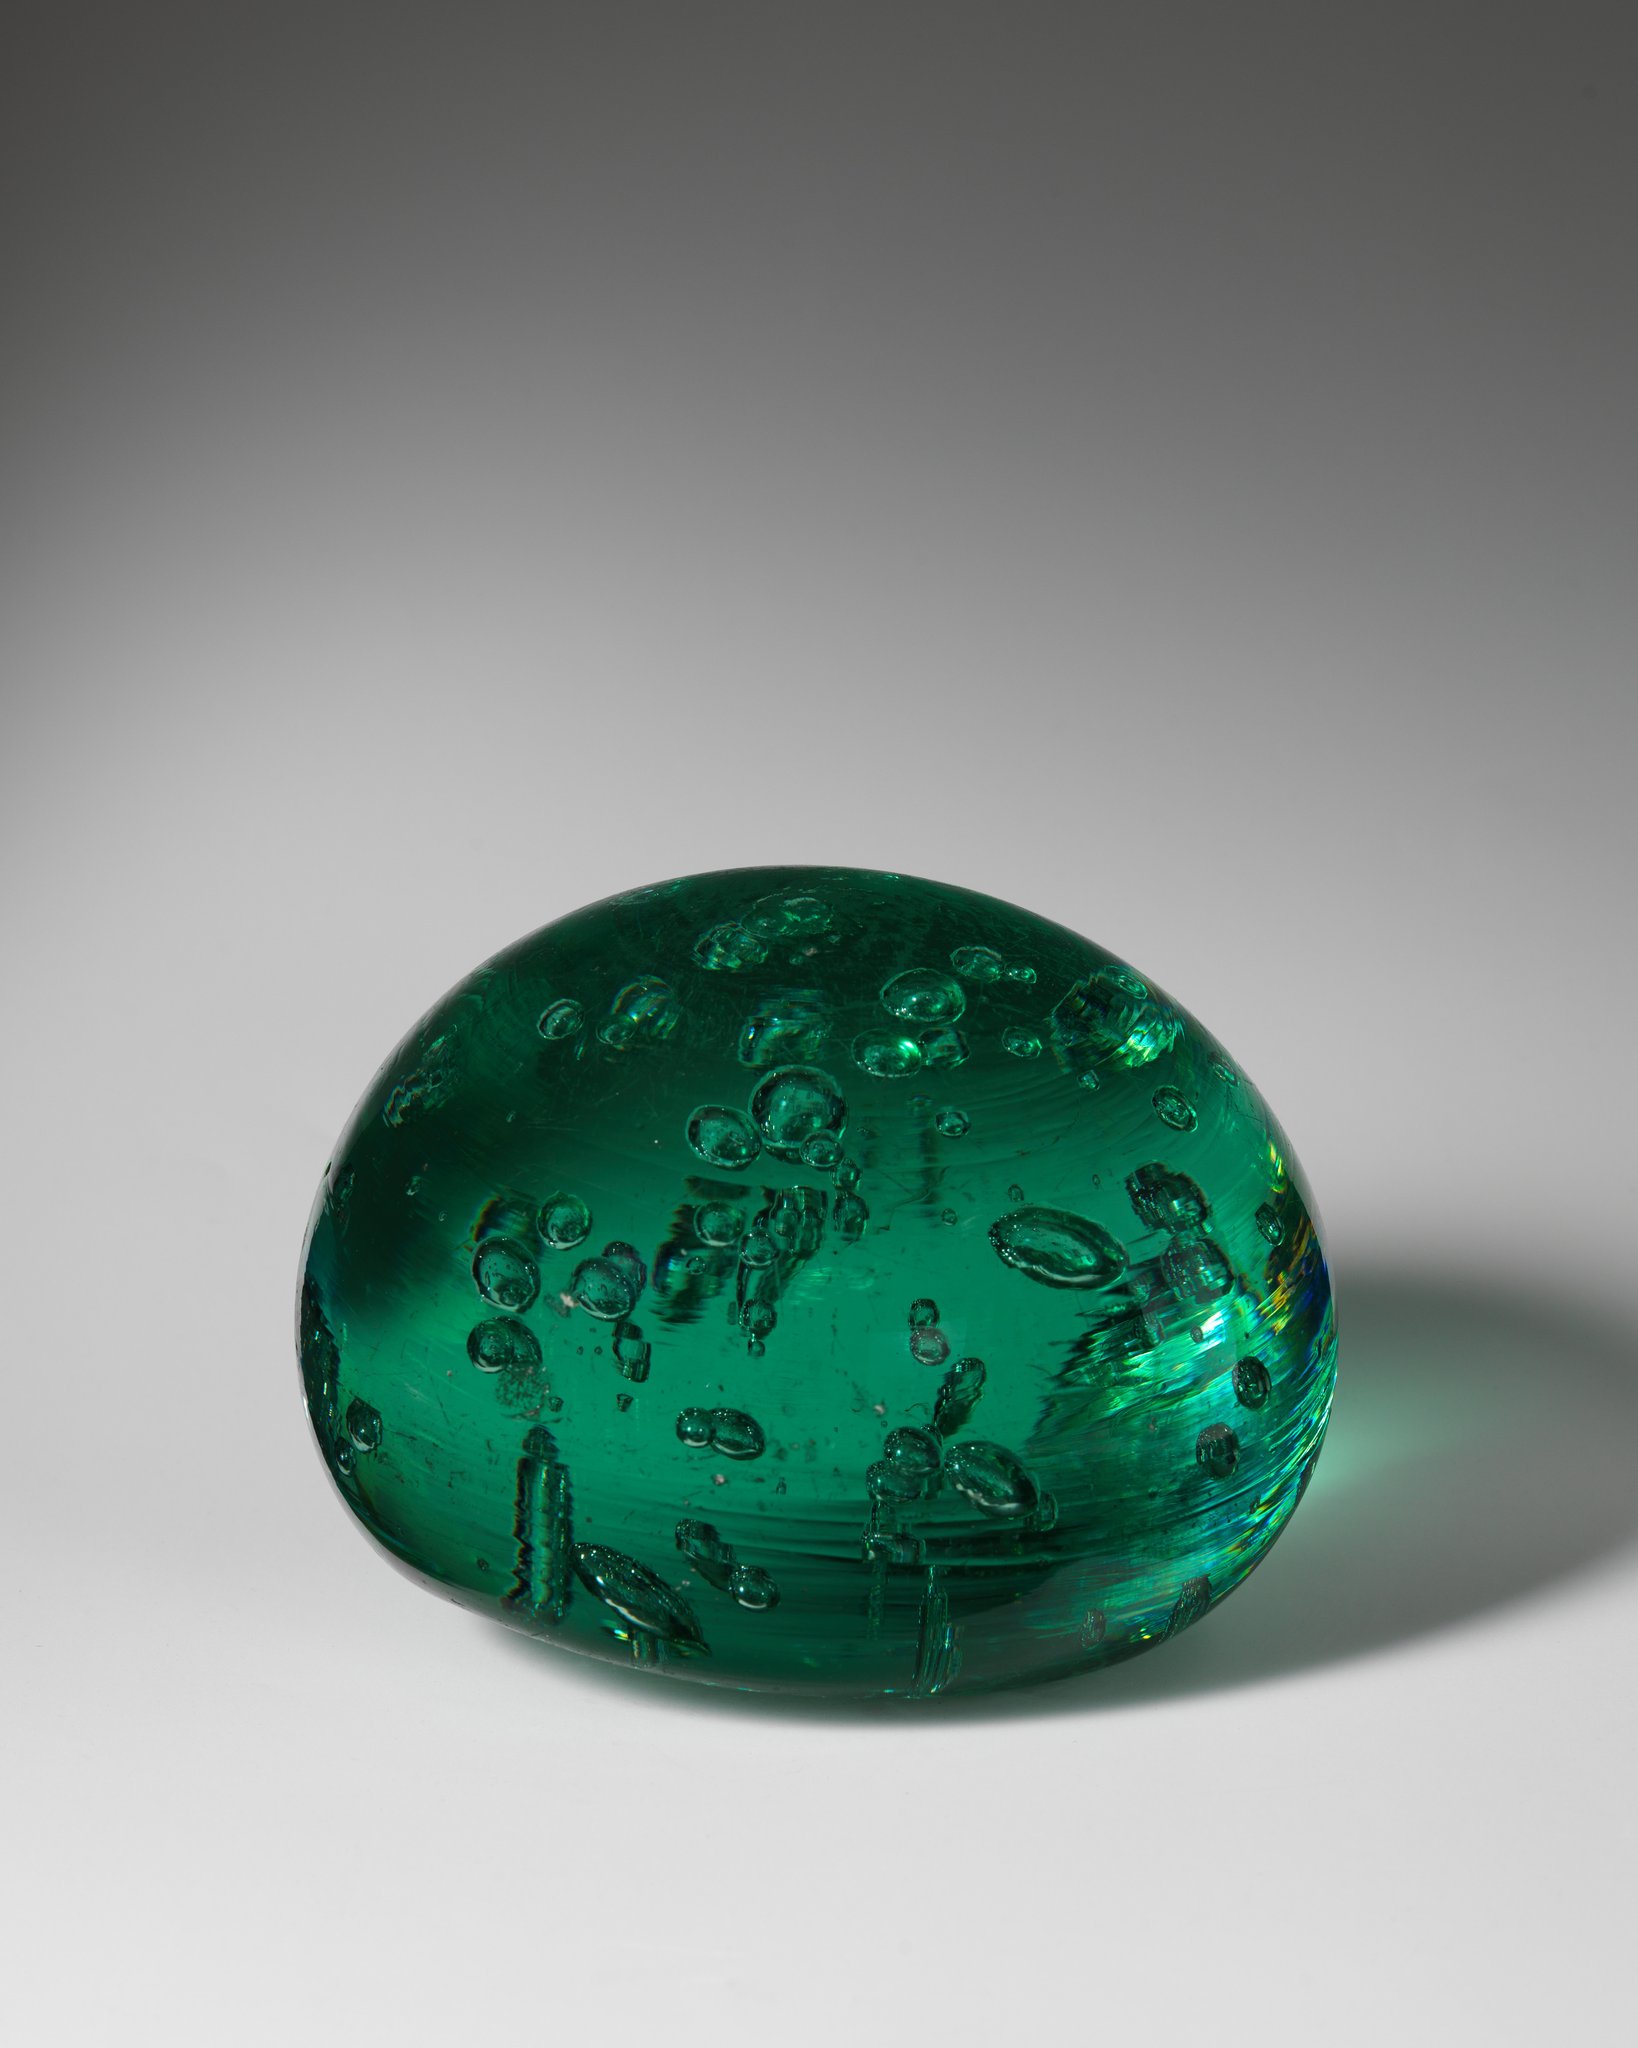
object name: door stop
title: Door stop (one of a pair)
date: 1801-1900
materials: glass